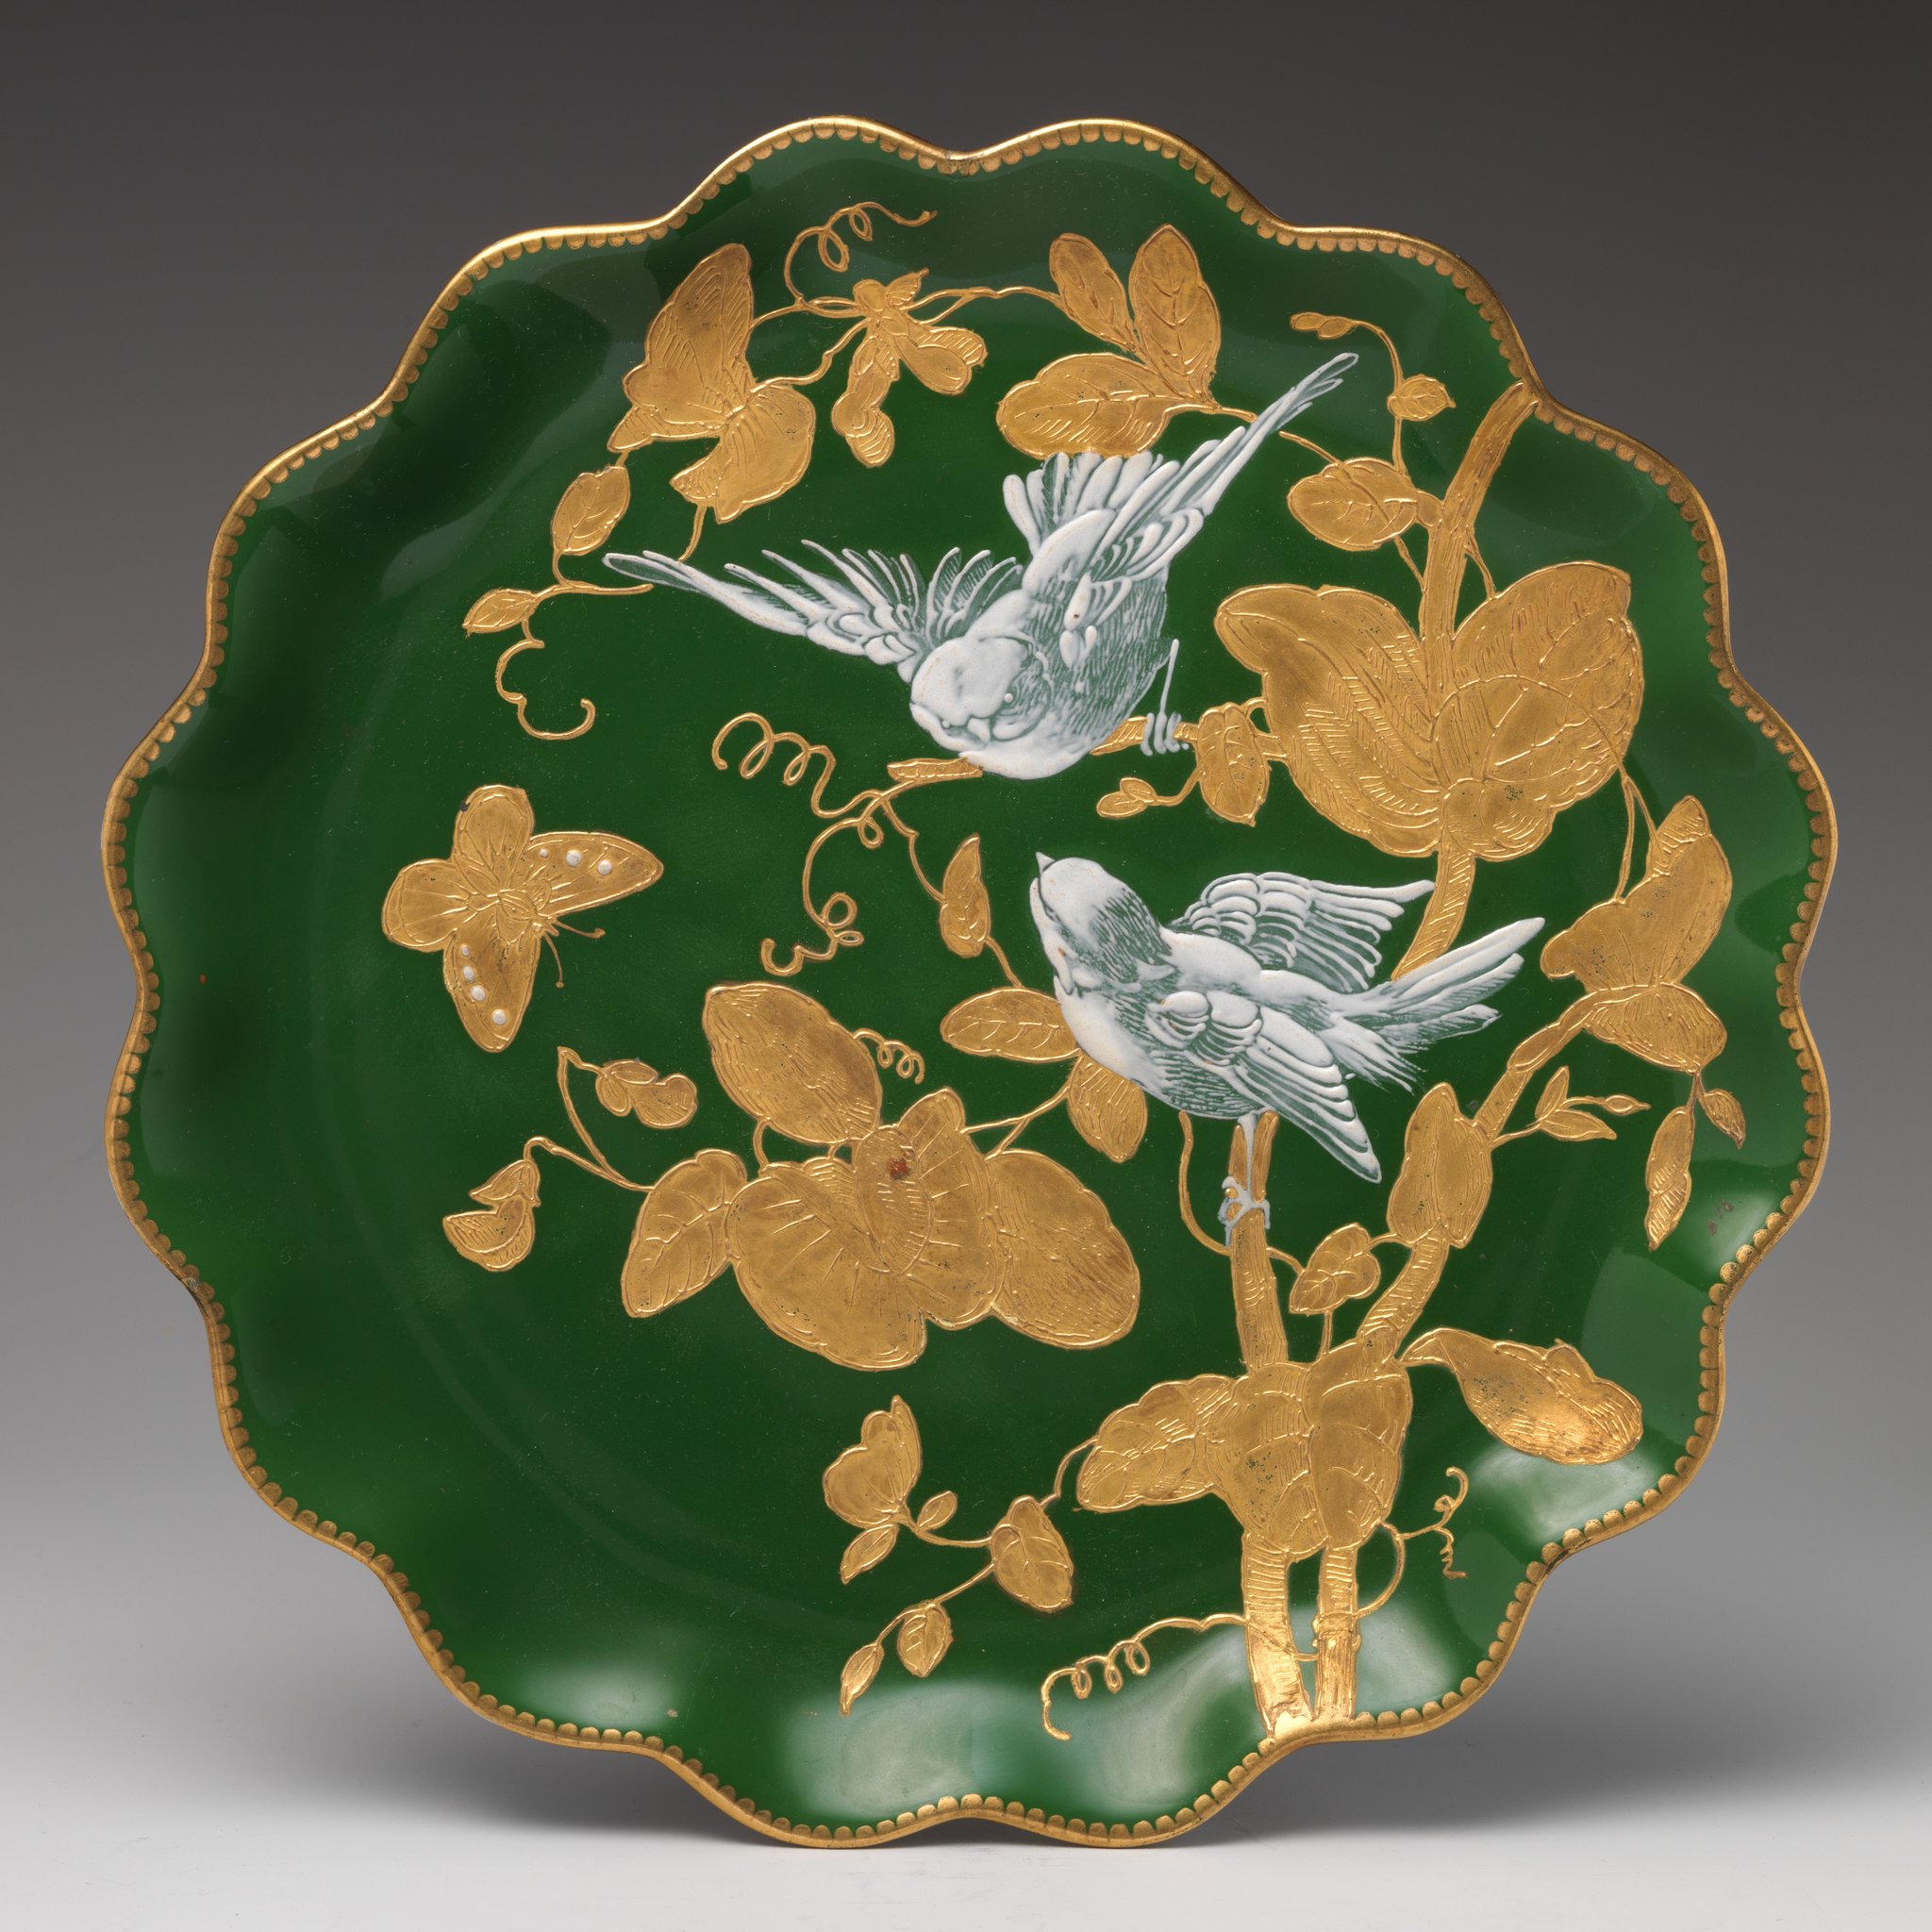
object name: charger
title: Scalloped rim charger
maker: coalport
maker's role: maker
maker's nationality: british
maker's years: 1794-1926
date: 1881-1891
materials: porcelain